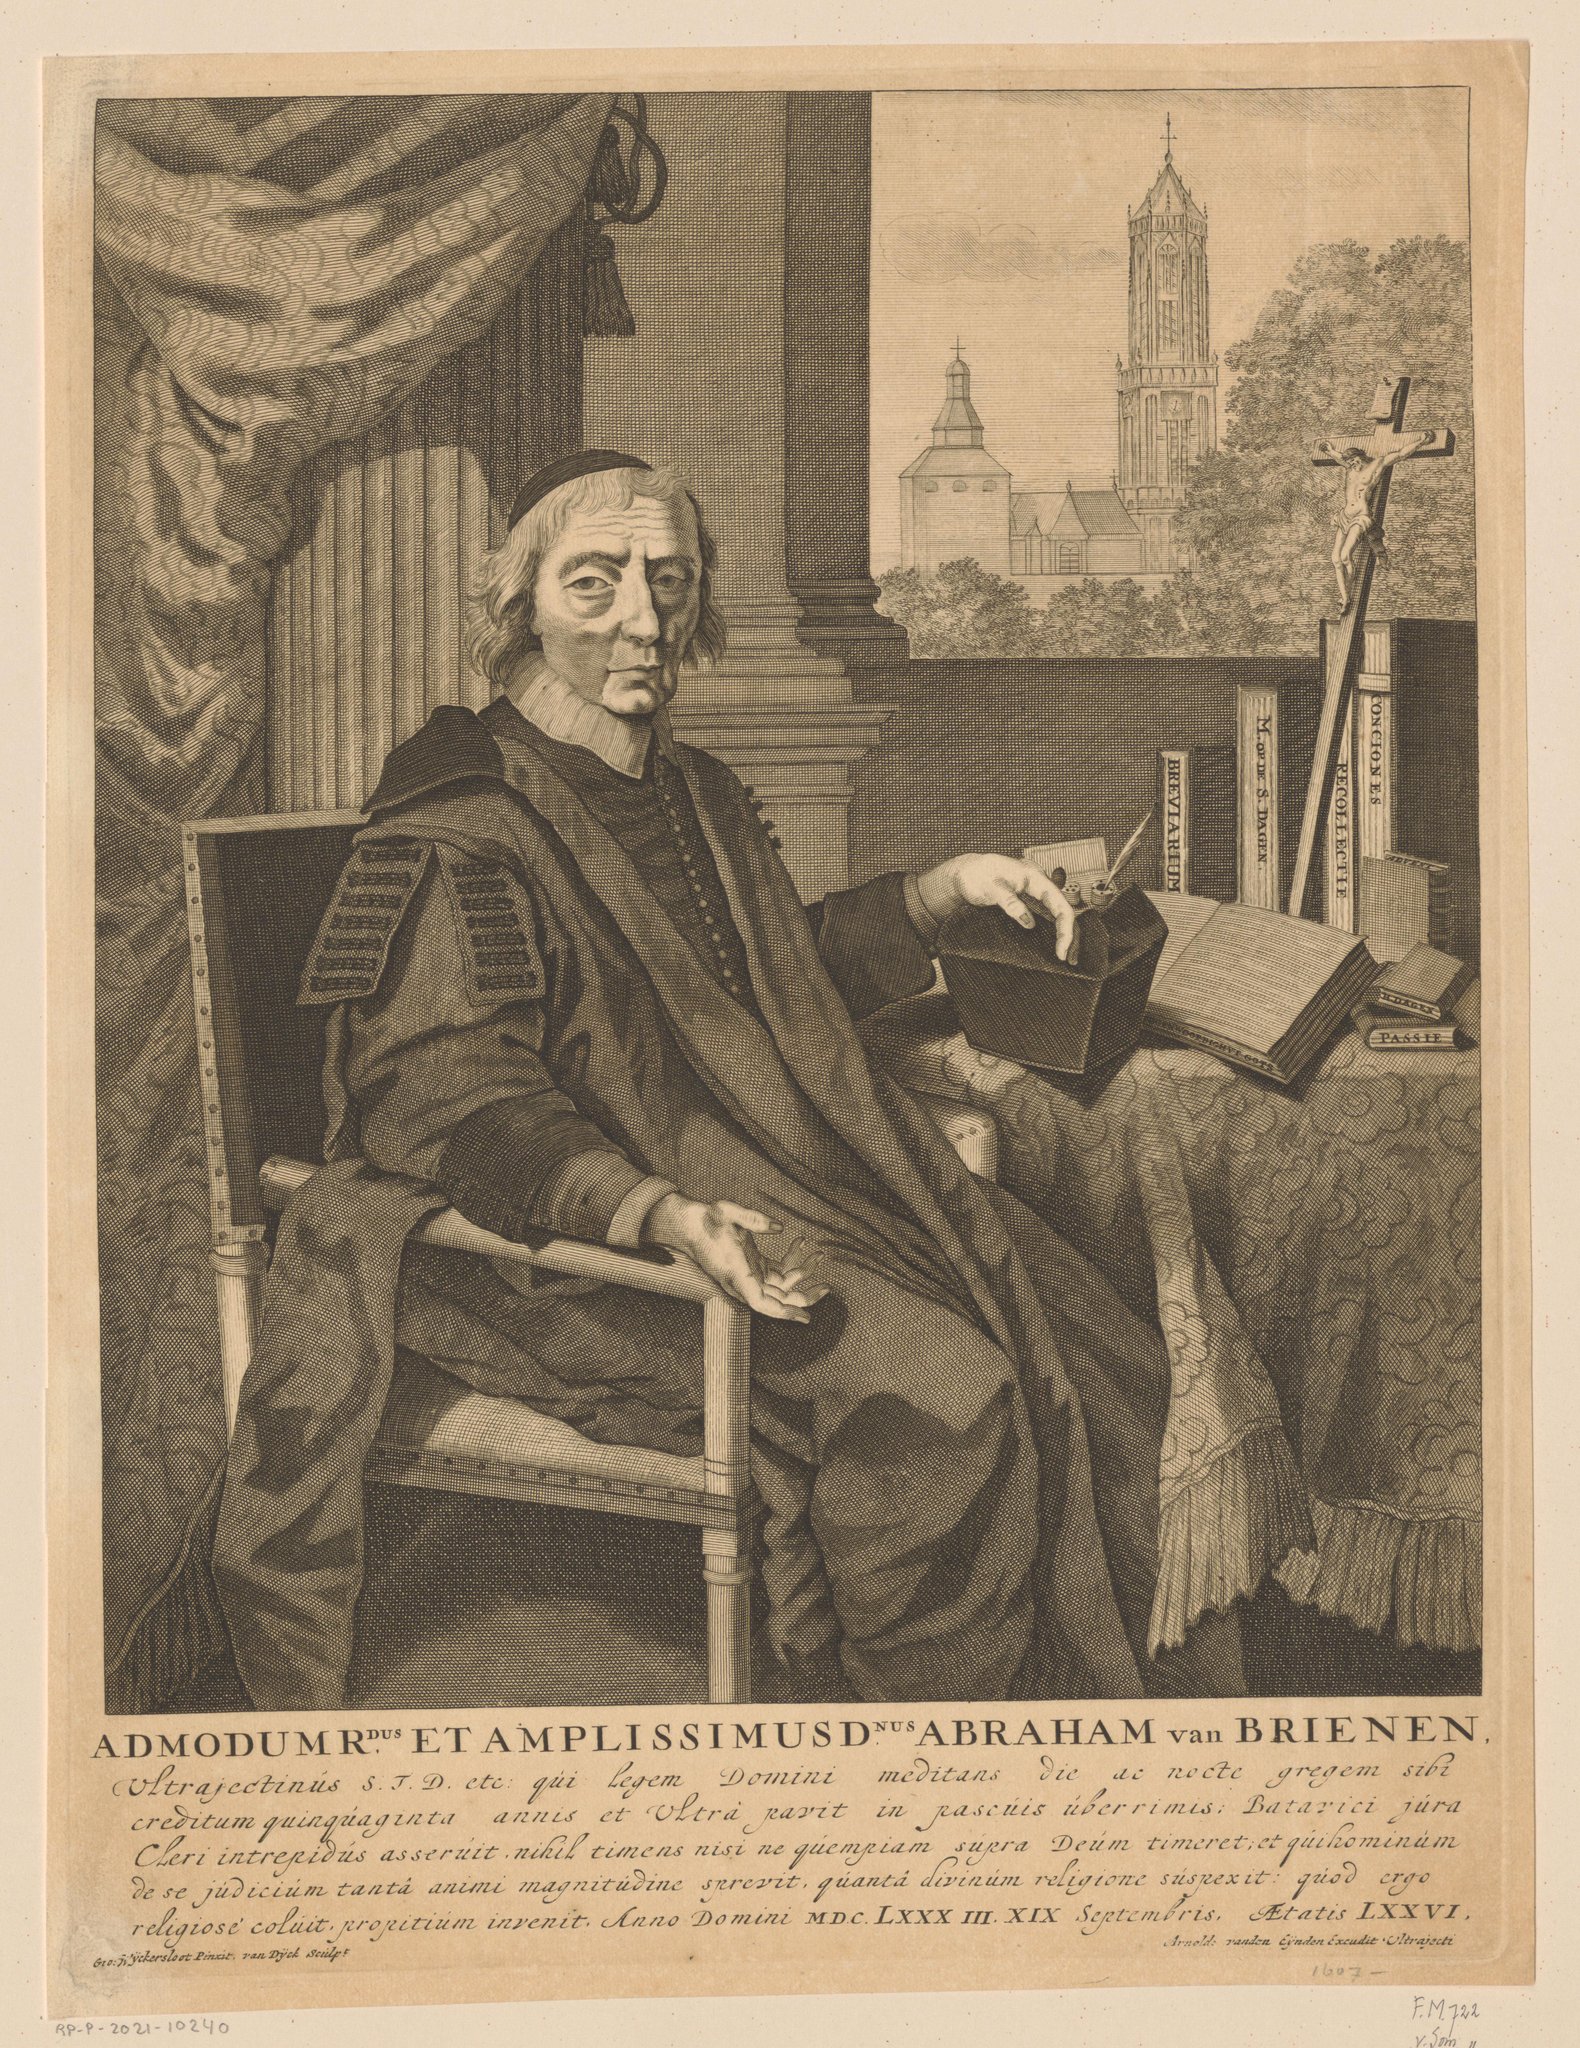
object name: print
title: Portret van Abraham van Brienen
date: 1683-1695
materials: paper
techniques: engraving, etching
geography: utrecht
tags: city-view in general; 'veduta', historical persons, functionaries and dignitaries ~ episcopal protestant churches, book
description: Met op de achtergrond de Domtoren en de Buurkerk in Utrecht.